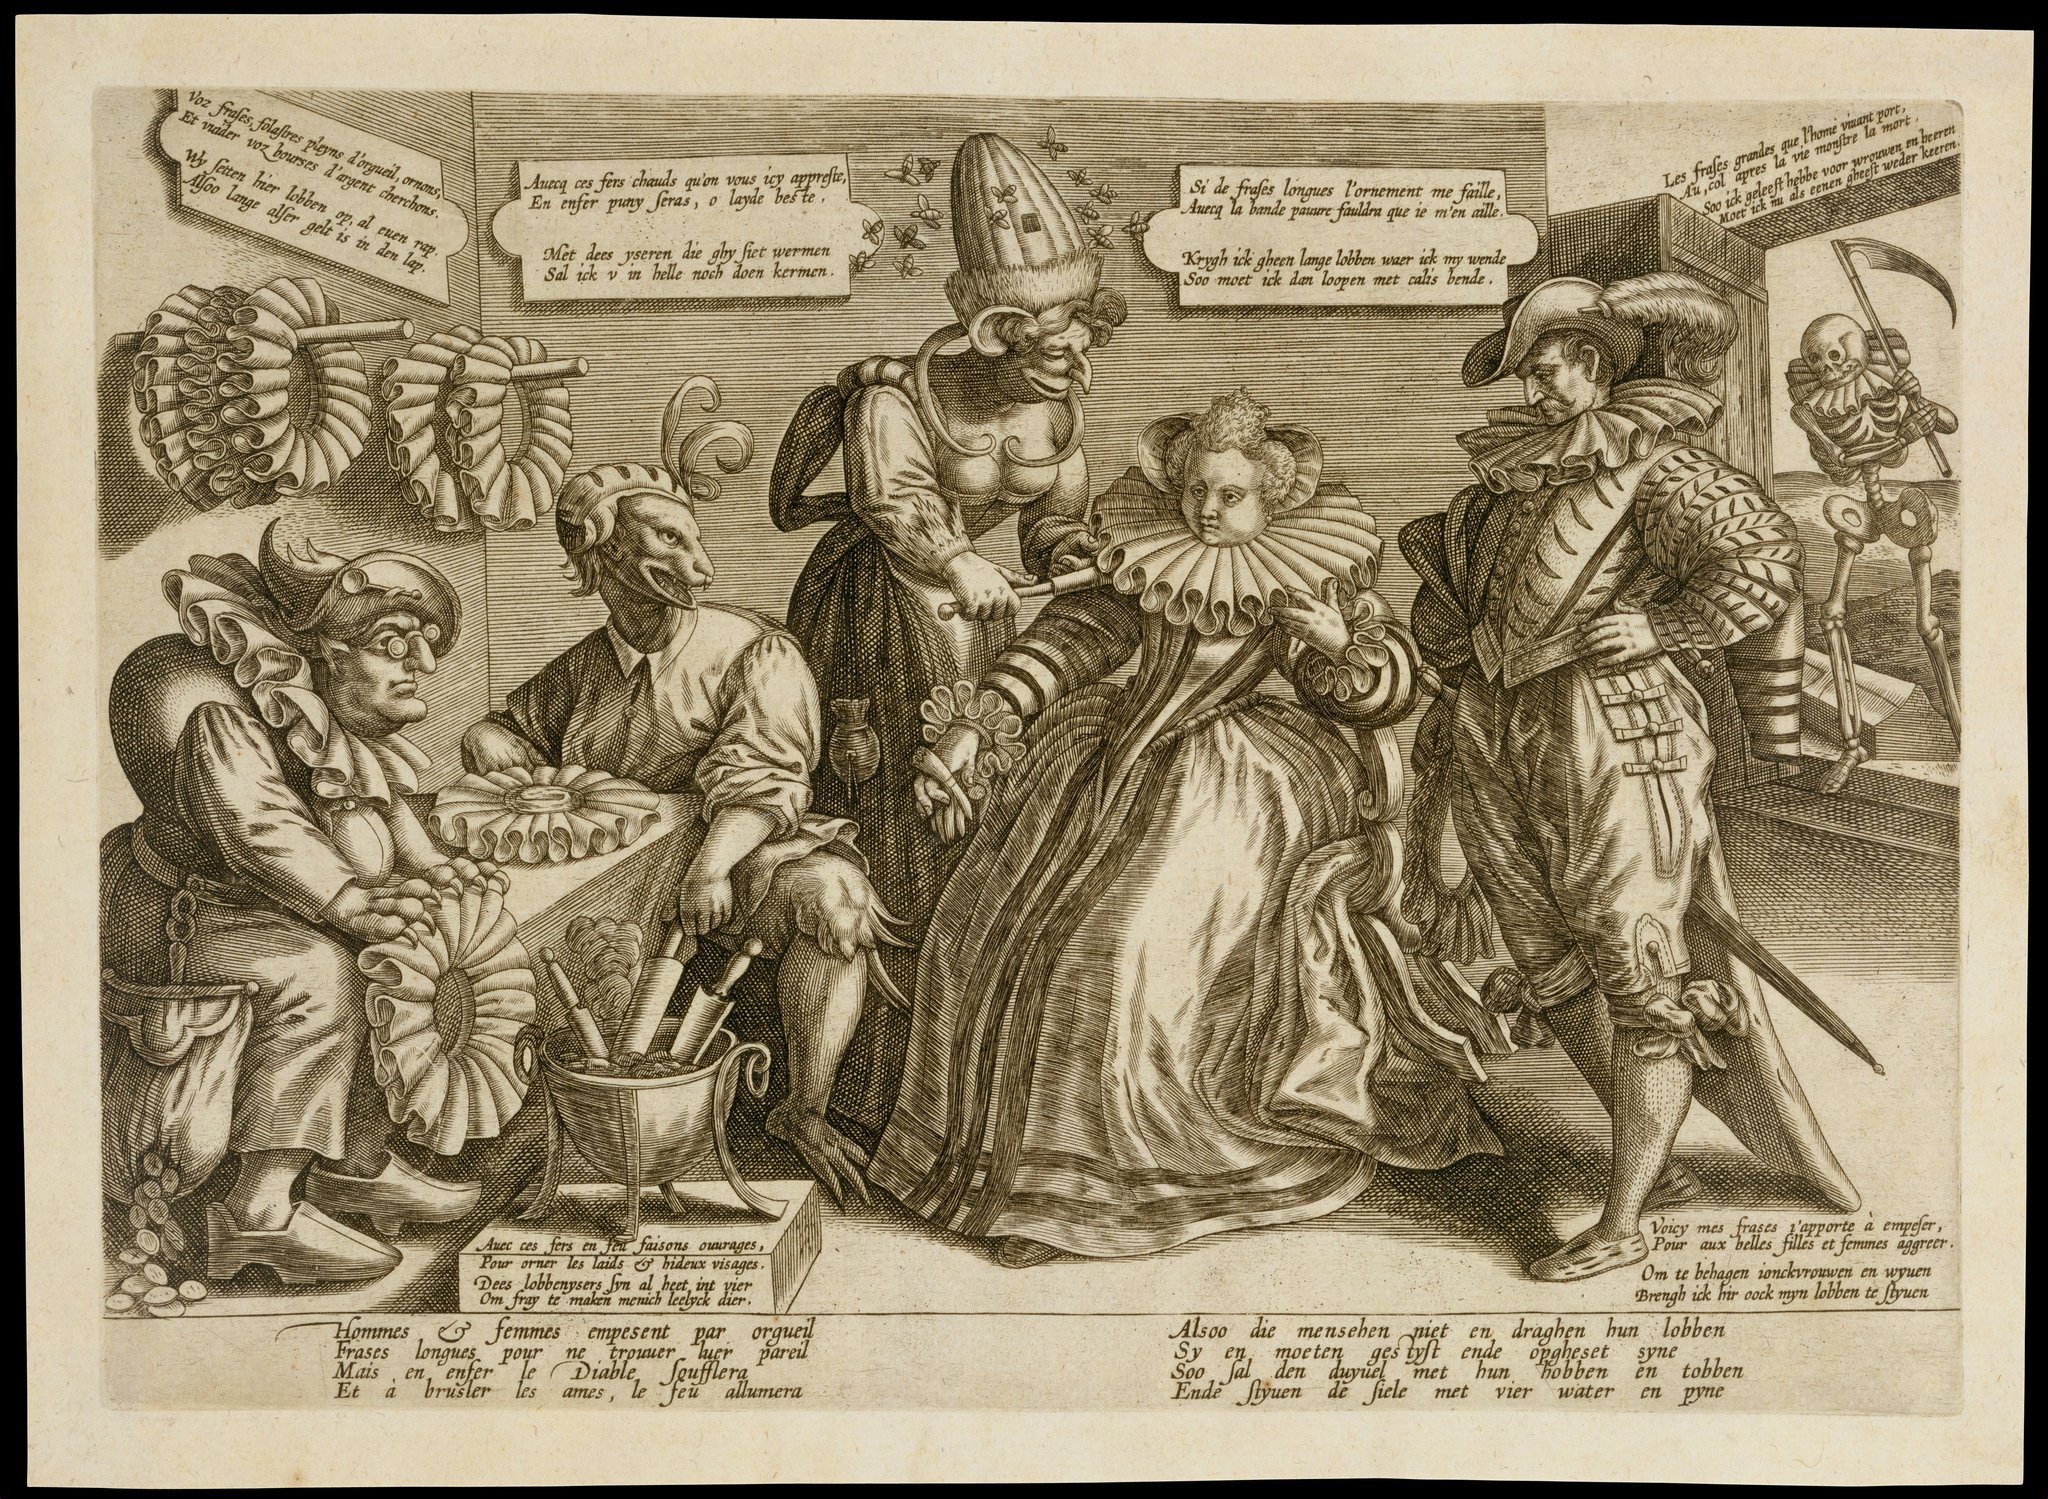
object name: engraving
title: The Pride of Women: Ruffs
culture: dutch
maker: maerten de vos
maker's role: artist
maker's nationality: netherlandish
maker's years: 1532-1603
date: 1600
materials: paper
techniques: engraving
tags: satire,skeletons,men,women,fashion